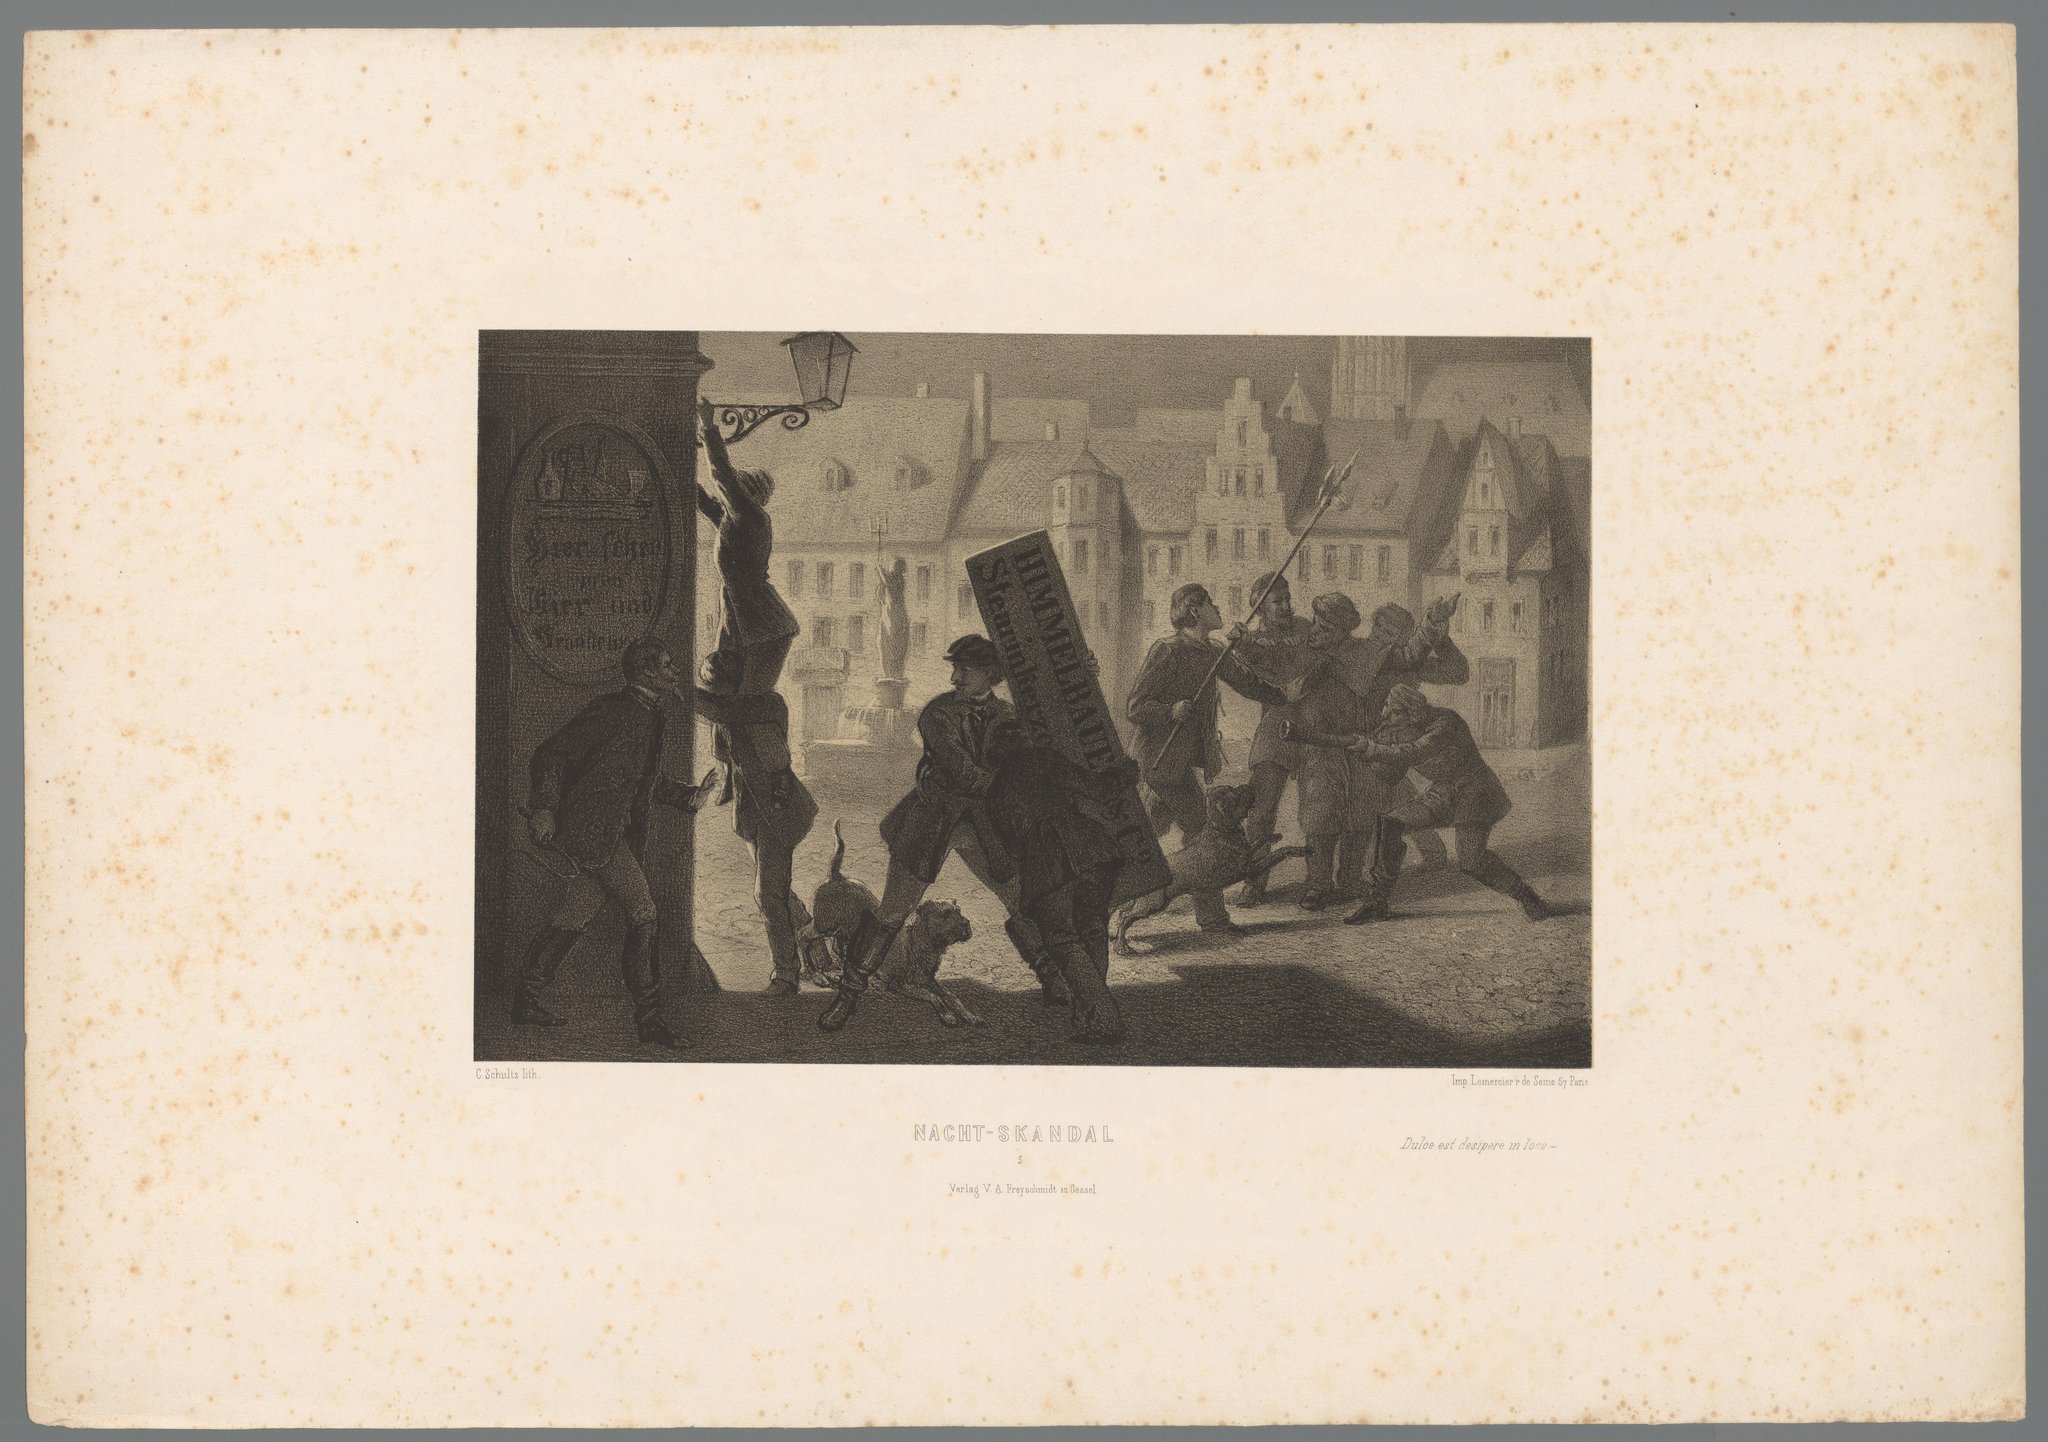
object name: print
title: Nachtelijk tafereel met studenten die zich misdragen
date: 1827-1887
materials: paper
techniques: lithograph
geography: kassel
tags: night patrol, student life, night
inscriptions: collector's mark: Lugt 2228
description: Groep uitgelaten studenten haalt een naambord van een gevel af en bespot een ordehandhaver. Onderaan genummerd: 5.